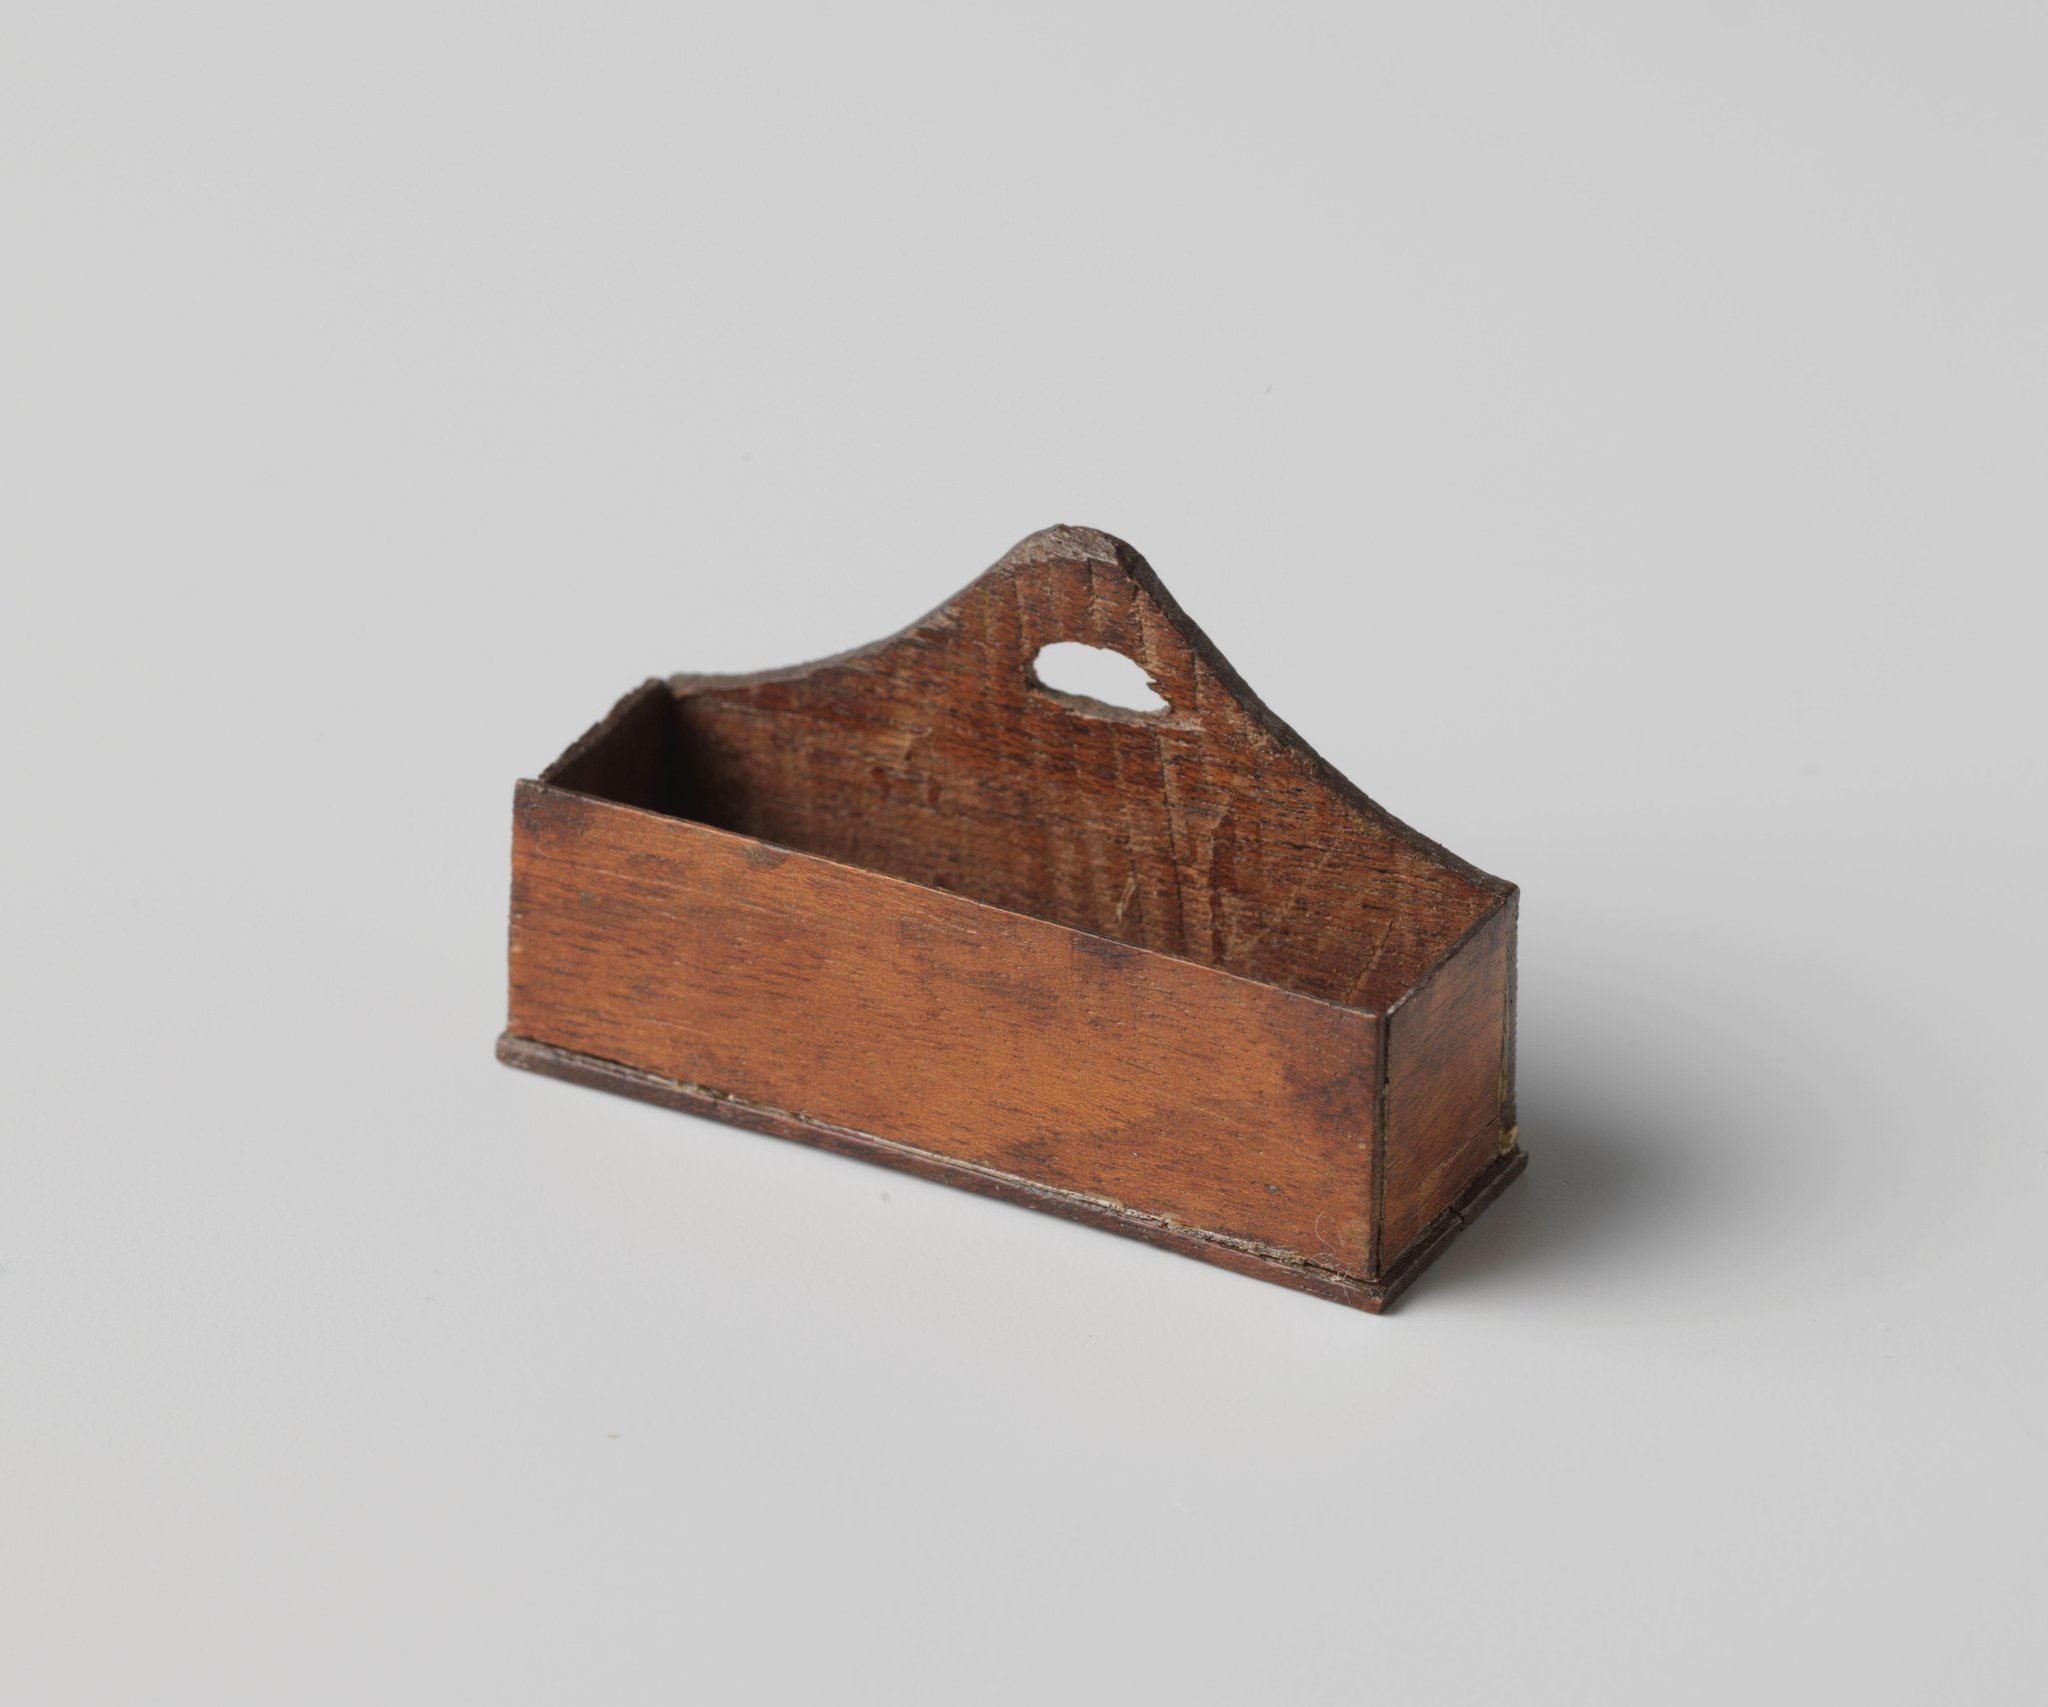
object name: miniature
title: Wandbak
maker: Anonymous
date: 1750-1800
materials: wood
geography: amsterdam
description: Wandbak van mahoniehout, met oog in achterplaat om op te hangen. Bestemd voor kaarsen, messen of zwavelstokken.